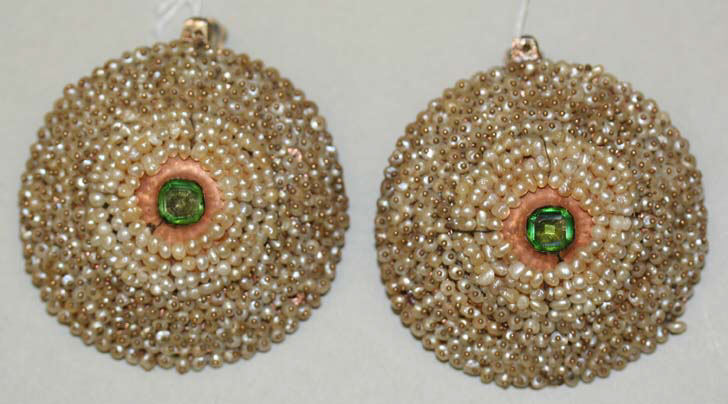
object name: earring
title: Earrings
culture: italian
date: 1801-1833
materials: pearl, silver